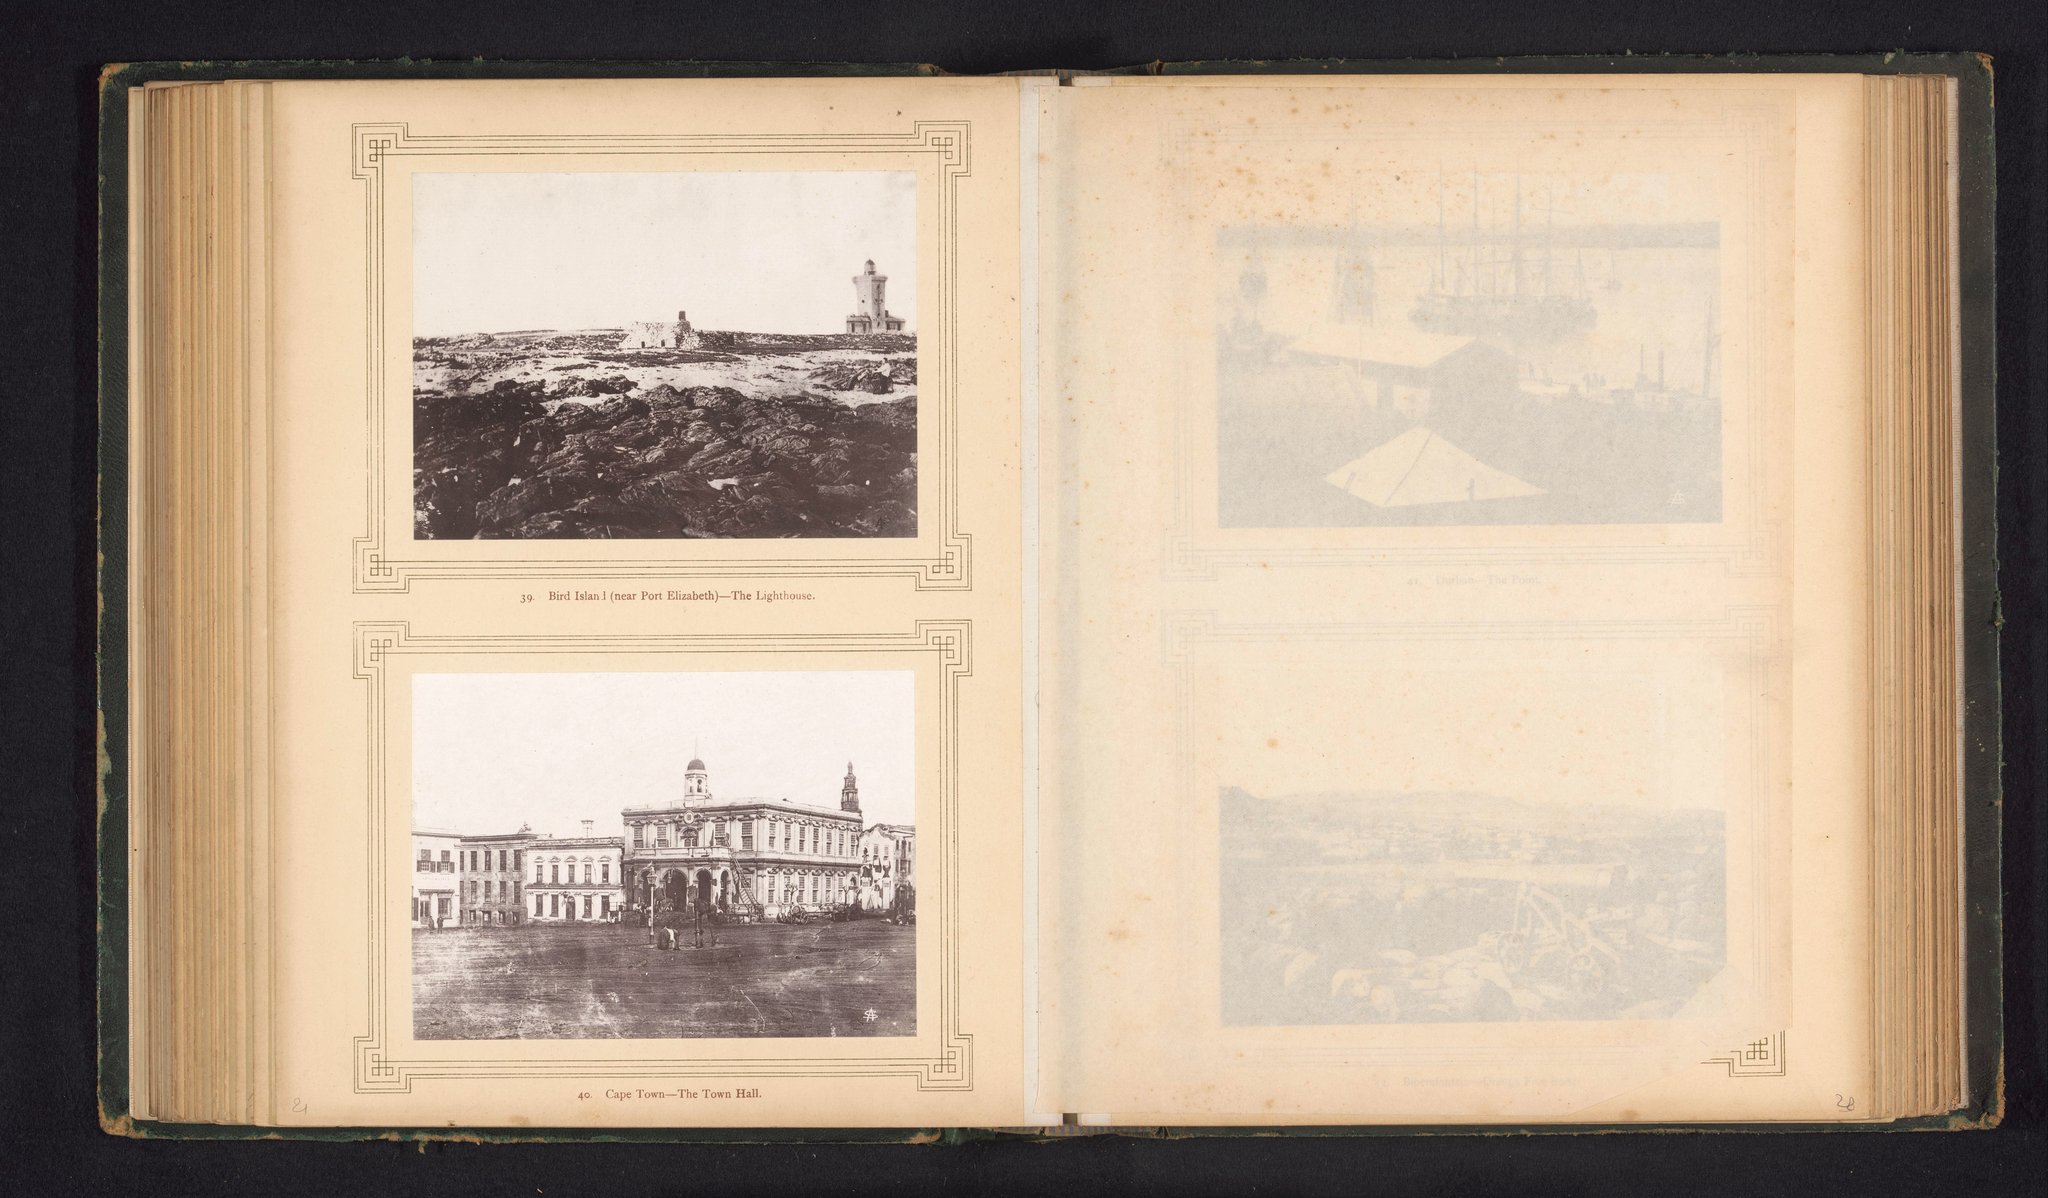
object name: page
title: Cape Town-The town hall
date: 1870-1880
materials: paper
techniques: photograph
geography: south africa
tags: lighthouse, lightship, townhall, façade (of house or building)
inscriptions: number: ‘39. 40.’, inscription: ‘SA’